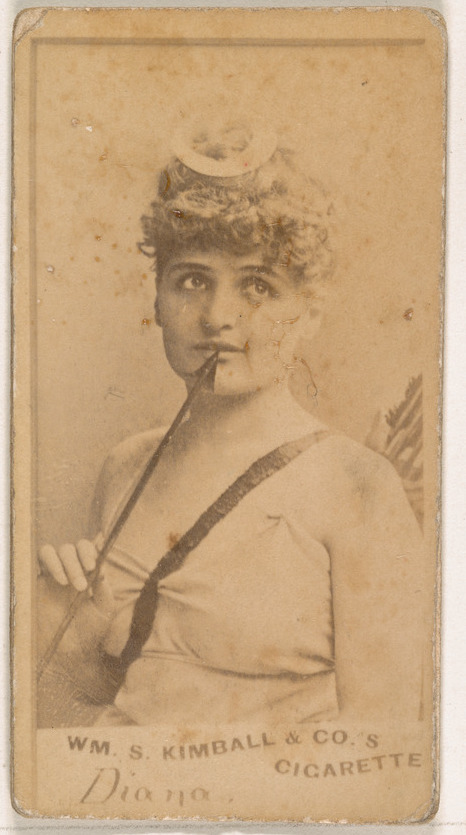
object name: photograph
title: Diana, from the Actresses series (N203) issued by Wm. S. Kimball & Co.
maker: william s. kimball & company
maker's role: publisher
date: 1889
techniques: color lithograph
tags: portraits,women,actresses